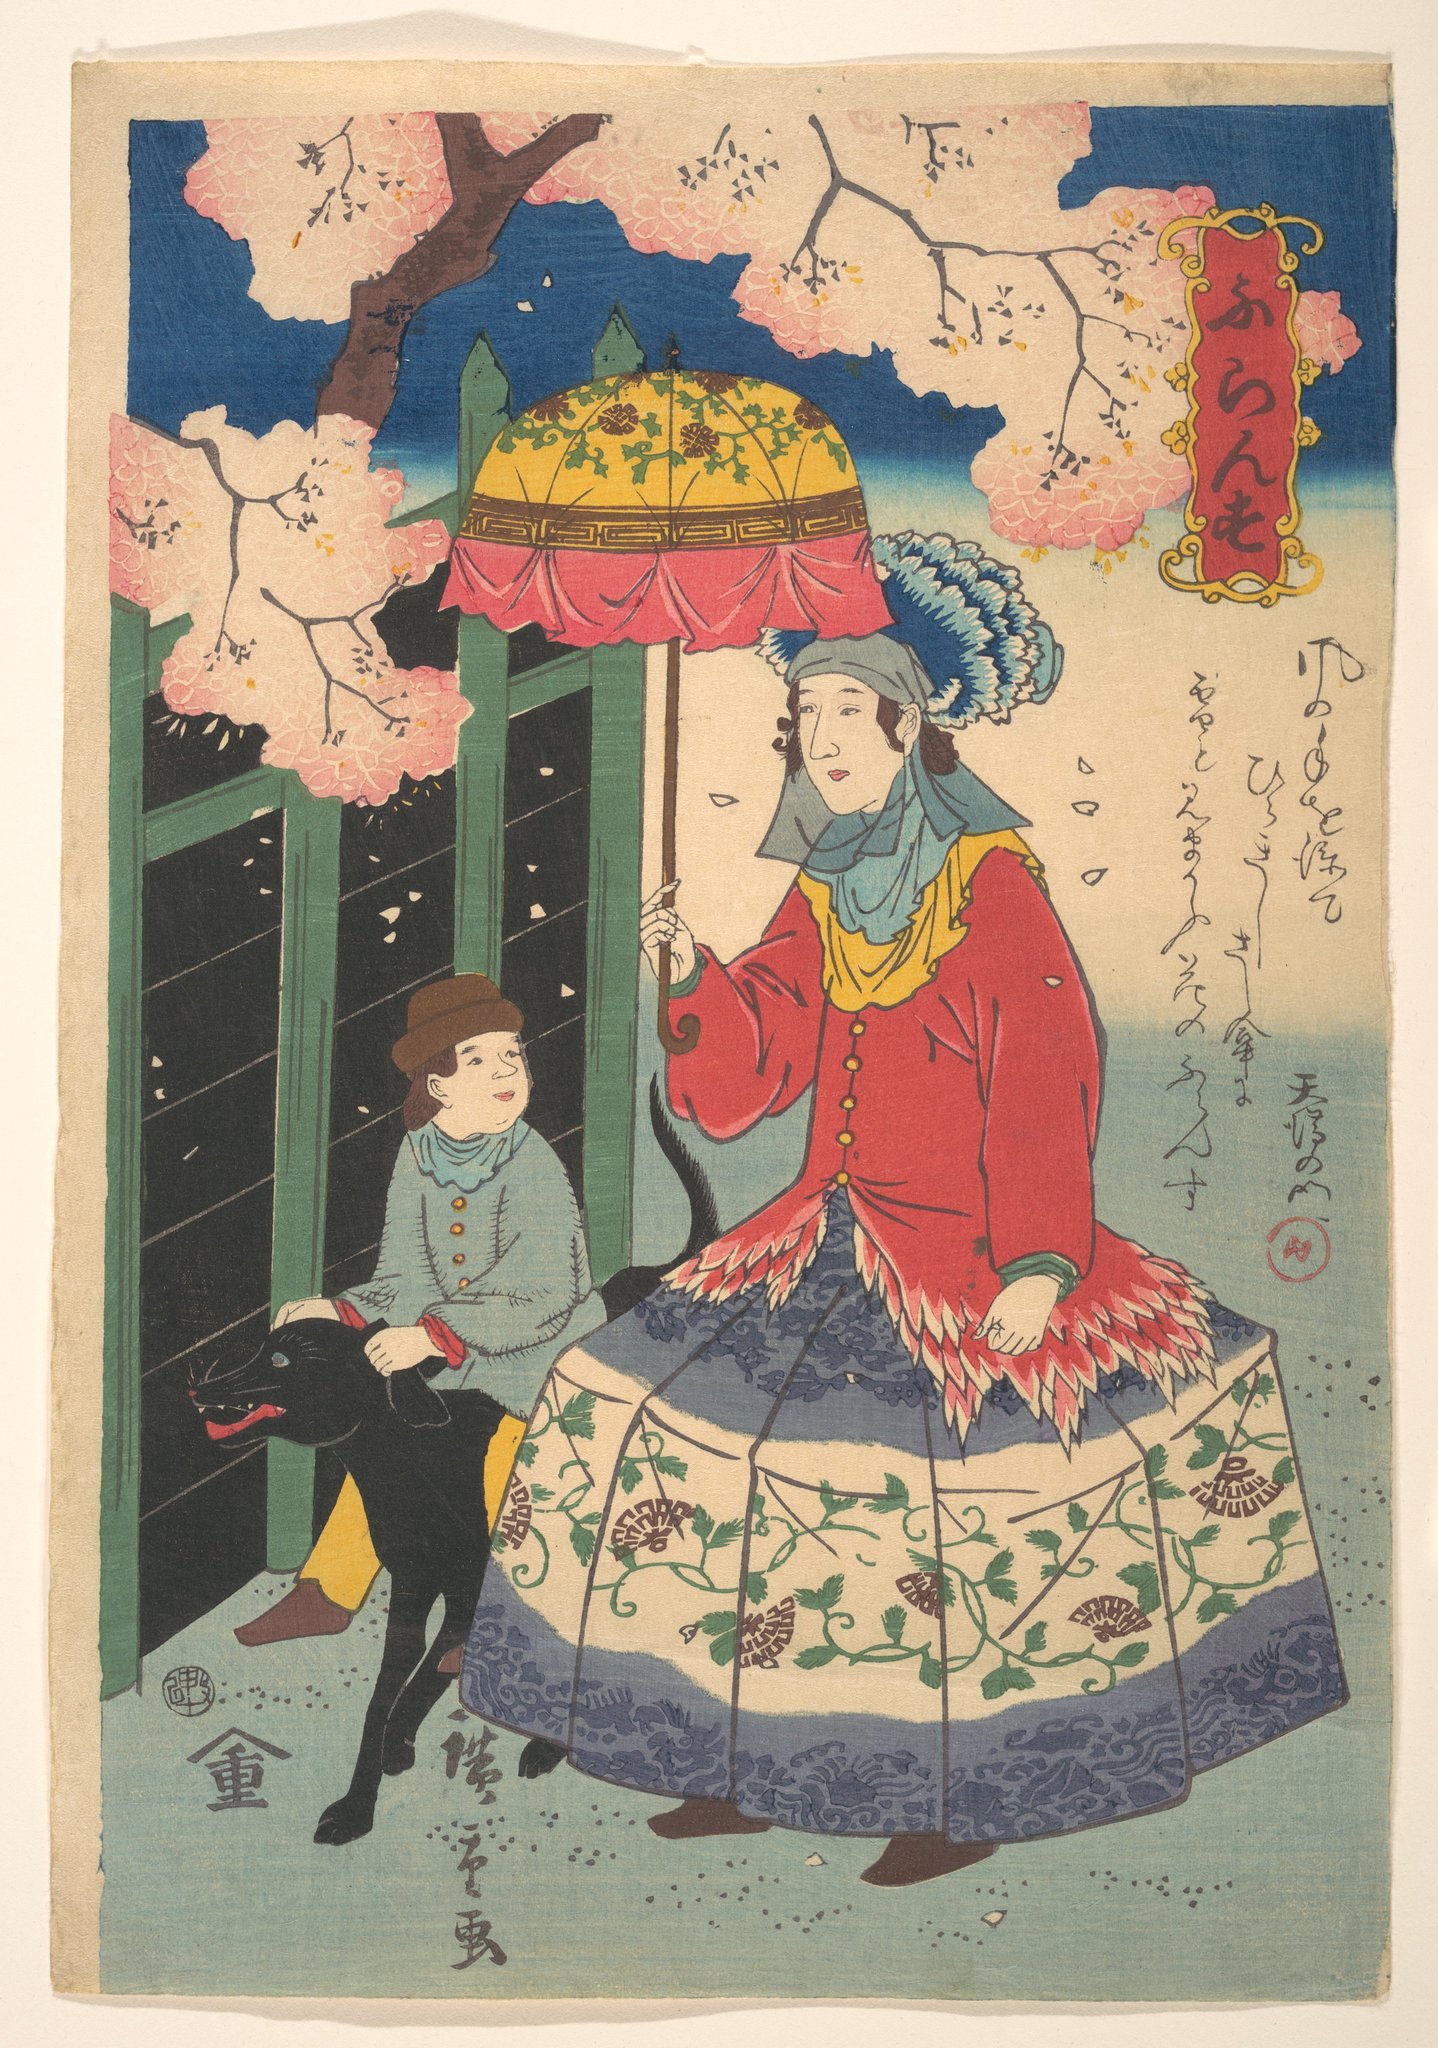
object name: print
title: French Woman, Her Child and Pet Dog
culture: japanese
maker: utagawa hiroshige ii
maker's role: artist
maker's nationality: japanese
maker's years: 1826-1869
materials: ink, paper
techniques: woodblock print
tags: boys,women,dogs,trees